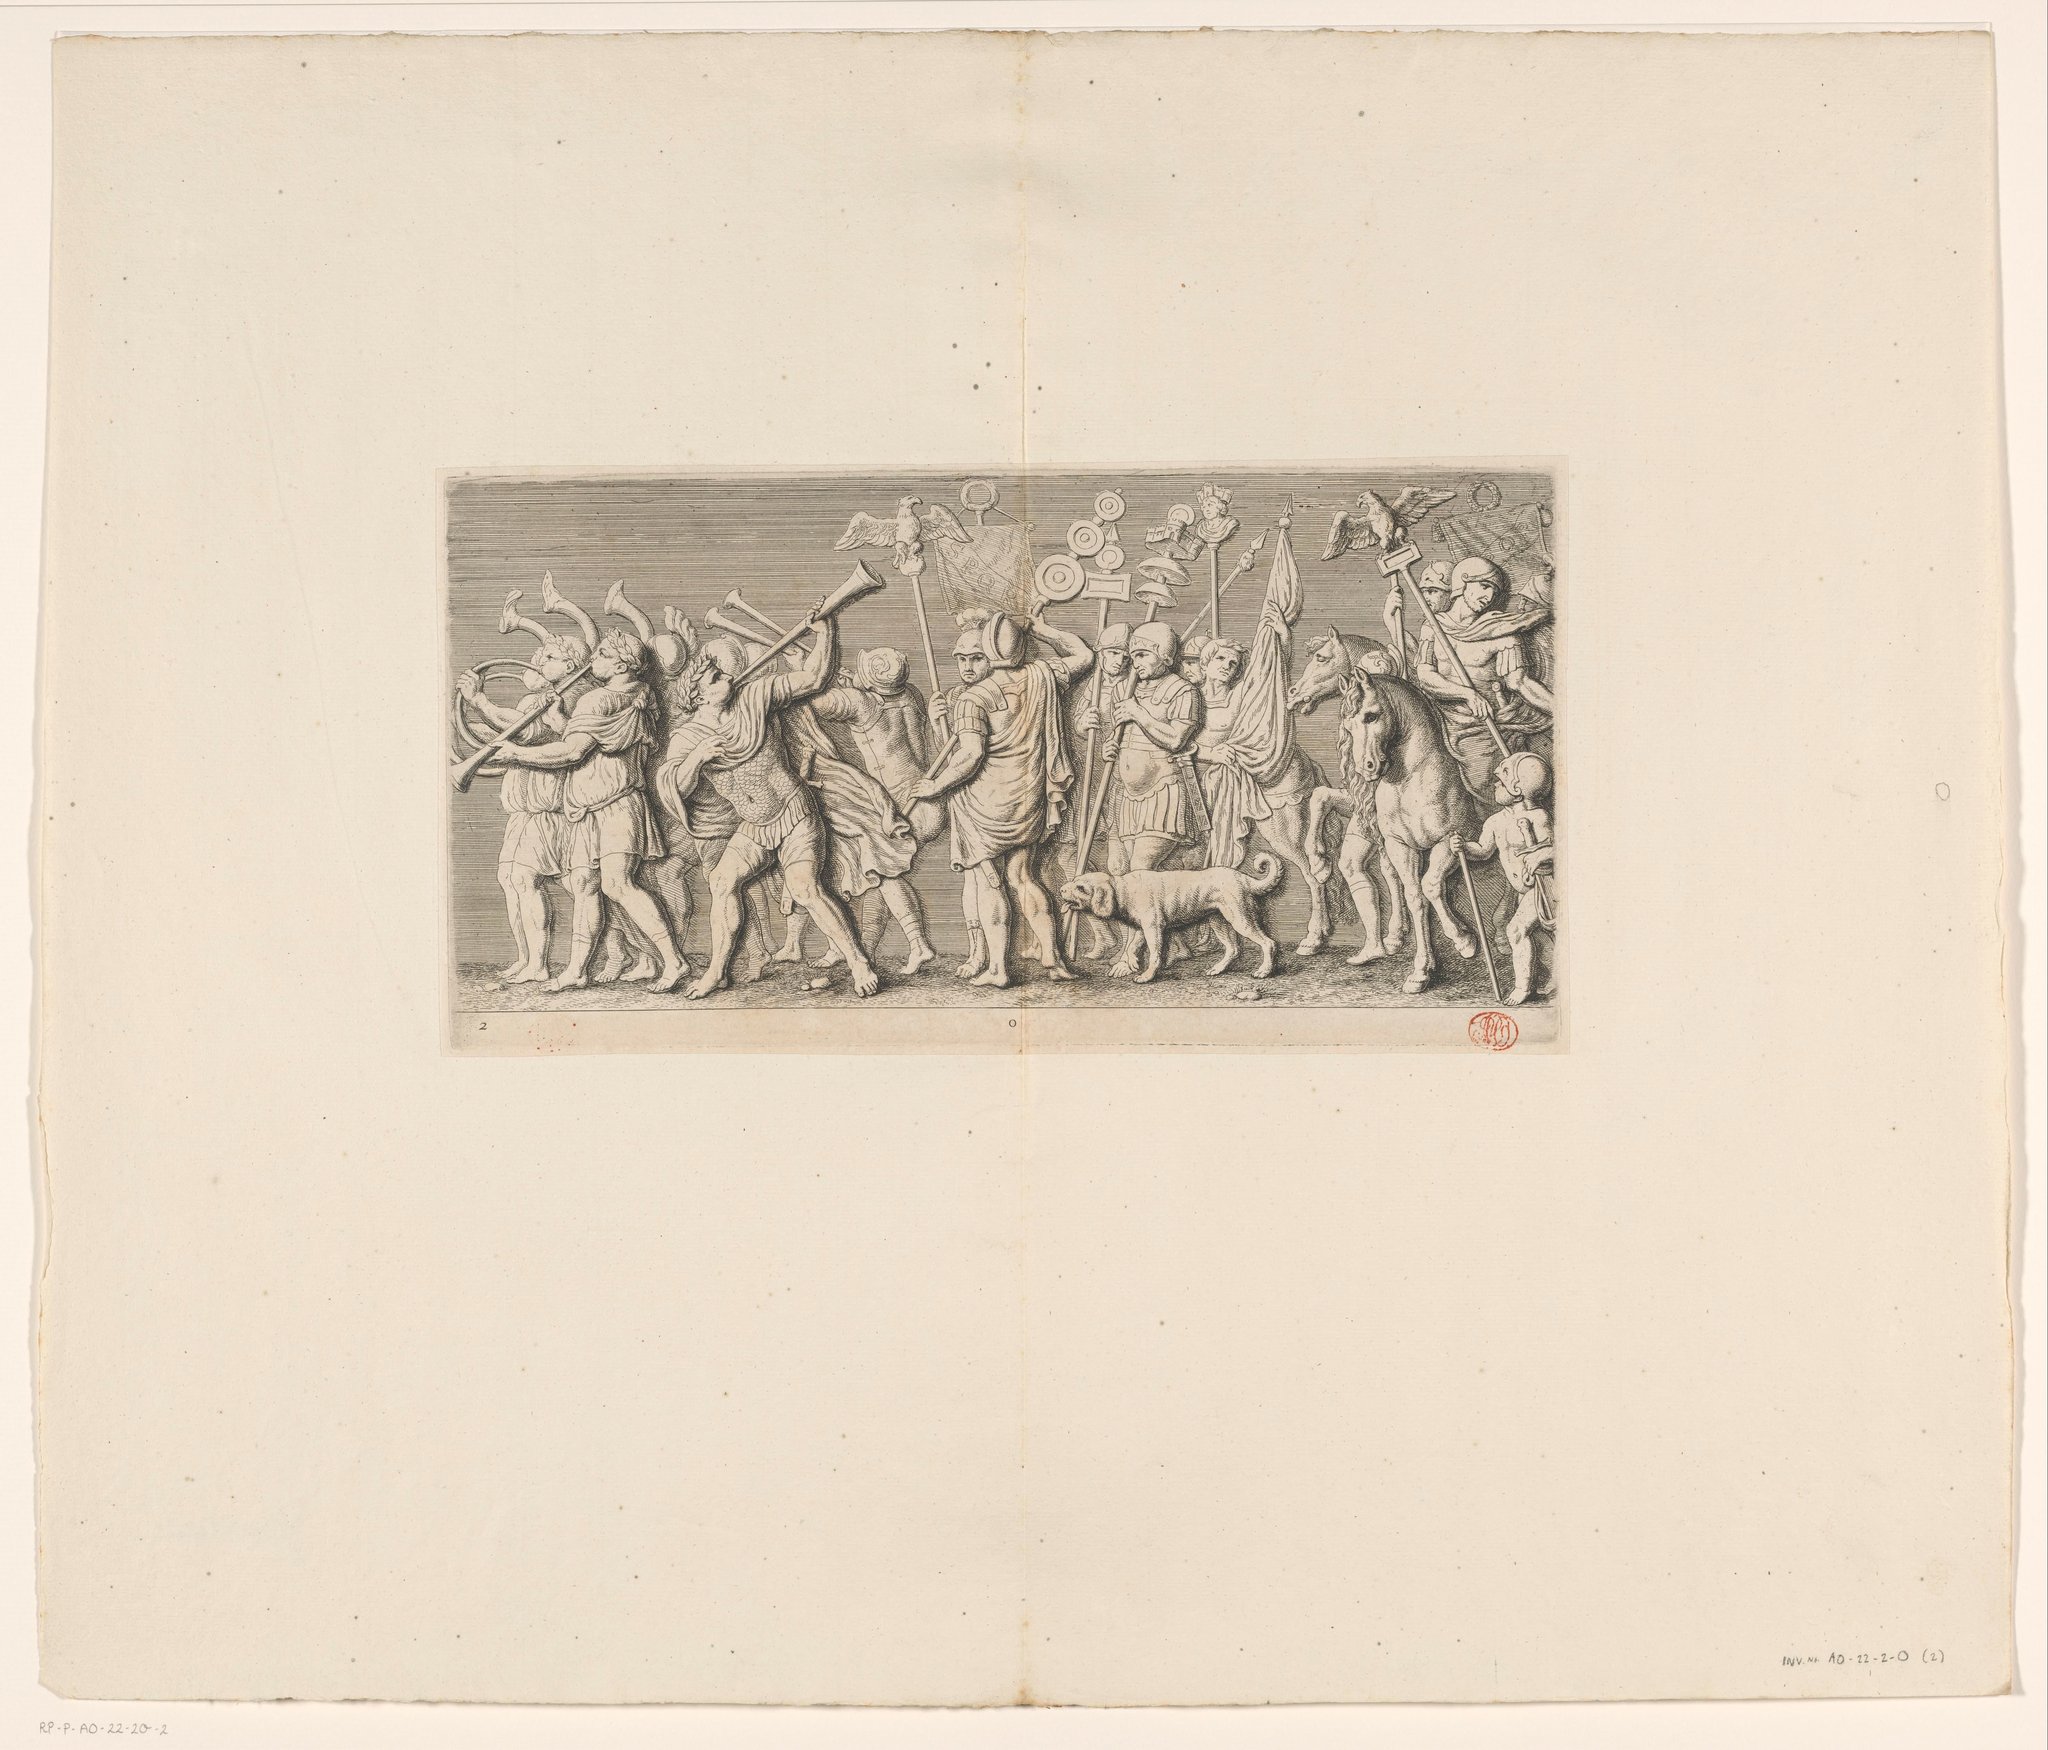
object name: book illustration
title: Fries met triomftocht van Quintus Fabius Maximus op schouw in Burgemeesterskamer van het Stadhuis op de Dam (tweede deel)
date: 1663-1665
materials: paper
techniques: engraving, etching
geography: amsterdam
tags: riding a horse, ass, or mule; rider, horseman, horn, trumpet, cornet, trombone, tuba, triumphal entry and public reception, pageant, 'entrée solennelle', 'joyeuse entrée', triumphs (allegorical and symbolic), conqueror triumphing, triumphal entry of victor, (military) flags and standards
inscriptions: collector's mark: Lugt 195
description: Aangezien er meerdere (in ieder geval vier) Quinti Fabii Maximi zijn geweest die consul waren en één of meerdere triomftochten hebben gekregen, is niet met zekerheid te zeggen om welke triomftocht en welke Quintus Fabius Maximus het gaat. Maar het is waarschijnlijk dat het gaat om Quintus Fabius Maximus Verrucosus Cunctator (ca. 275 v.Chr. - 203 v.Chr.), die is afgebeeld op het schilderij van Jan Lievens dat boven de schouw hangt. Op dit schilderij is te zien hoe hij, in 213 v.Chr., op bevel van zijn naamgenoot en zoon Quintus Fabius Maximus - die in dat jaar consul was - van zijn paard afstijgt. Zijn zoon is maar eenmaal consul geweest en heeft geen triomfen behaald. Prent gebruikt in: Secunca pars Praecipuarum effigierum ac ornamentorum amplissime Curiae Amstelrodamensis maiori ex parte in cadido marmore effectorum per Artum Quellinium eiusdem Civitatis Statuarium / Het tweede deel Van de voornaemste Statuen ende Cieraten van 't konst-rijcke Stadt-huys van Amstelredam 'tmeeste in Marmer gemaeckt door Artus Quellinus Beelthouwer der voorseyde Stadt. Amsterdam: Artus Quellinus (I), 1663. Zie RP-P-AO-22-2-1 voor bijhorende titelpagina. Zie RP-P-AO-22-2-2 voor bijhorend register. Zie RP-P-AO-22-2A, RP-P-AO-22-2B, RP-P-AO-22-2C-1, RP-P-AO-22-2C-2, RP-P-AO-22-2C-3, RP-P-AO-22-2C-4, RP-P-AO-22-2D-1, RP-P-AO-22-2D-2, RP-P-AO-22-2D-3, RP-P-AO-22-2E-1, RP-P-AO-22-2E-2, RP-P-AO-22-2E-3, RP-P-AO-22-2E-4, RP-P-AO-22-2F-1, RP-P-AO-22-2F-2, RP-P-AO-22-2F-3, RP-P-AO-22-2G, RP-P-AO-22-2H, RP-P-AO-22-2I, RP-P-AO-22-2K, RP-P-AO-22-2L, RP-P-AO-22-2M, RP-P-AO-22-2N, RP-P-AO-22-2O-1, RP-P-AO-22-2O-3, RP-P-AO-22-2O-4, RP-P-AO-22-2O-5, RP-P-AO-22-2O-6, RP-P-AO-22-2O-7, RP-P-AO-22-2P-1, RP-P-AO-22-2P-2, RP-P-AO-22-2Q-1, RP-P-AO-22-2Q-2, RP-P-AO-22-2Q-3, RP-P-AO-22-2R-1, RP-P-AO-22-2R-2, RP-P-AO-22-2R-3, RP-P-AO-22-2S, RP-P-AO-22-2T-1, RP-P-AO-22-2T-2, RP-P-AO-22-2T-3, RP-P-AO-22-2T-4, RP-P-AO-22-2V-1, RP-P-AO-22-2V-2, RP-P-AO-22-2W-1, RP-P-AO-22-2W-2, RP-P-AO-22-2X-1, RP-P-AO-22-2X-2 en RP-P-AO-22-2X-3 voor andere prenten uit deze publicatie. Zelfde staat van prent ook gebruikt in: Secunca pars Praecipuarum effigierum ac ornamentorum amplissime Curiae Amstelrodamensis maiori ex parte in cadido marmore effectorum per Artum Quellinium eiusdem Civitatis Statuarium / Het tweede deel Van de voornaemste Statuen ende Cieraten van 't konst-rijcke Stadt-huys van Amstelredam 'tmeeste in Marmer gemaeckt door Artus Quellinus Beelthouwer der voorseyde Stadt. Amsterdam: Frederik de Wit, 1668. Latere staat van prent ook gebruikt in: Architecture peinture et sculpture de la Maison de Ville d'Amsterdam, representee en CIX. figures en taille-douce (…). Amsterdam: David Mortier, 1719. En in: Architecture peinture et sculpture de la Maison de Ville d'Amsterdam, representee en CIX. figures en taille-douce (…). Amsterdam: Gerard Valck, 1719. En in: Bouw schilder en beeldhouwkonst, van het Stadhuis te Amsteldam, vertoont in CIX figuuren (…). Amsterdam: Covens & Mortier & Covens Jr., s.a. (1774-1783).